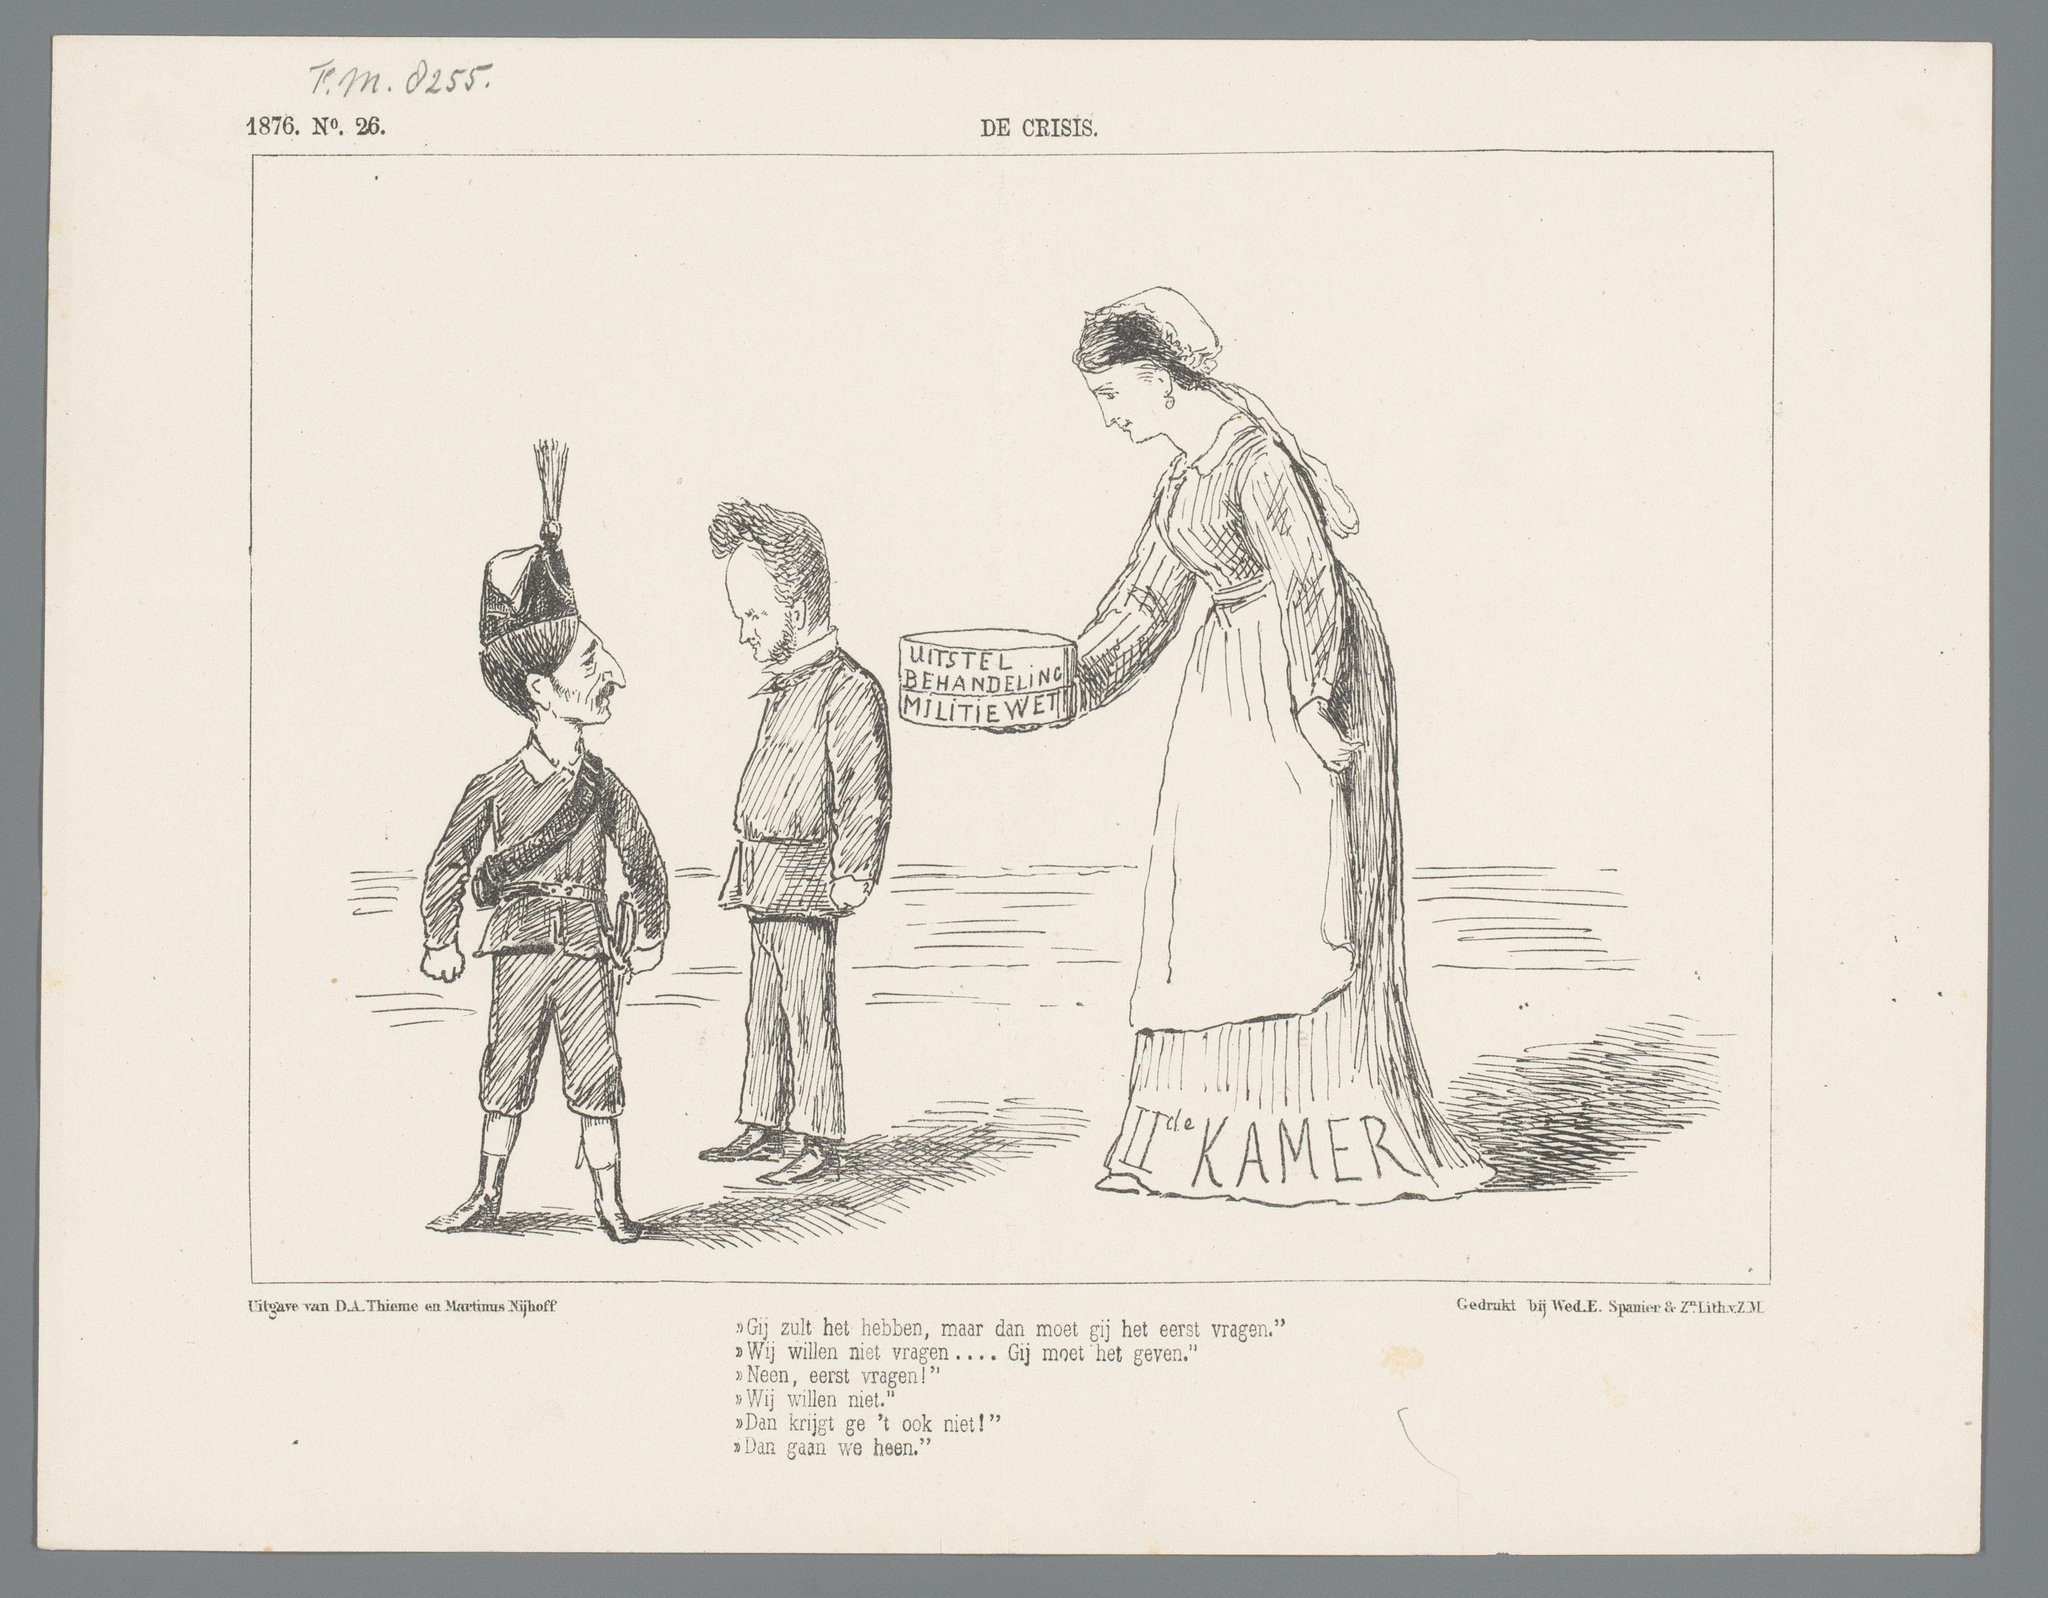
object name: print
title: Spotprent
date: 1876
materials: paper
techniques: lithograph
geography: the hague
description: Spotprent . Plaat verschenen bij het weekblad De Nederlandsche Spectator, nr. 26, 1876.